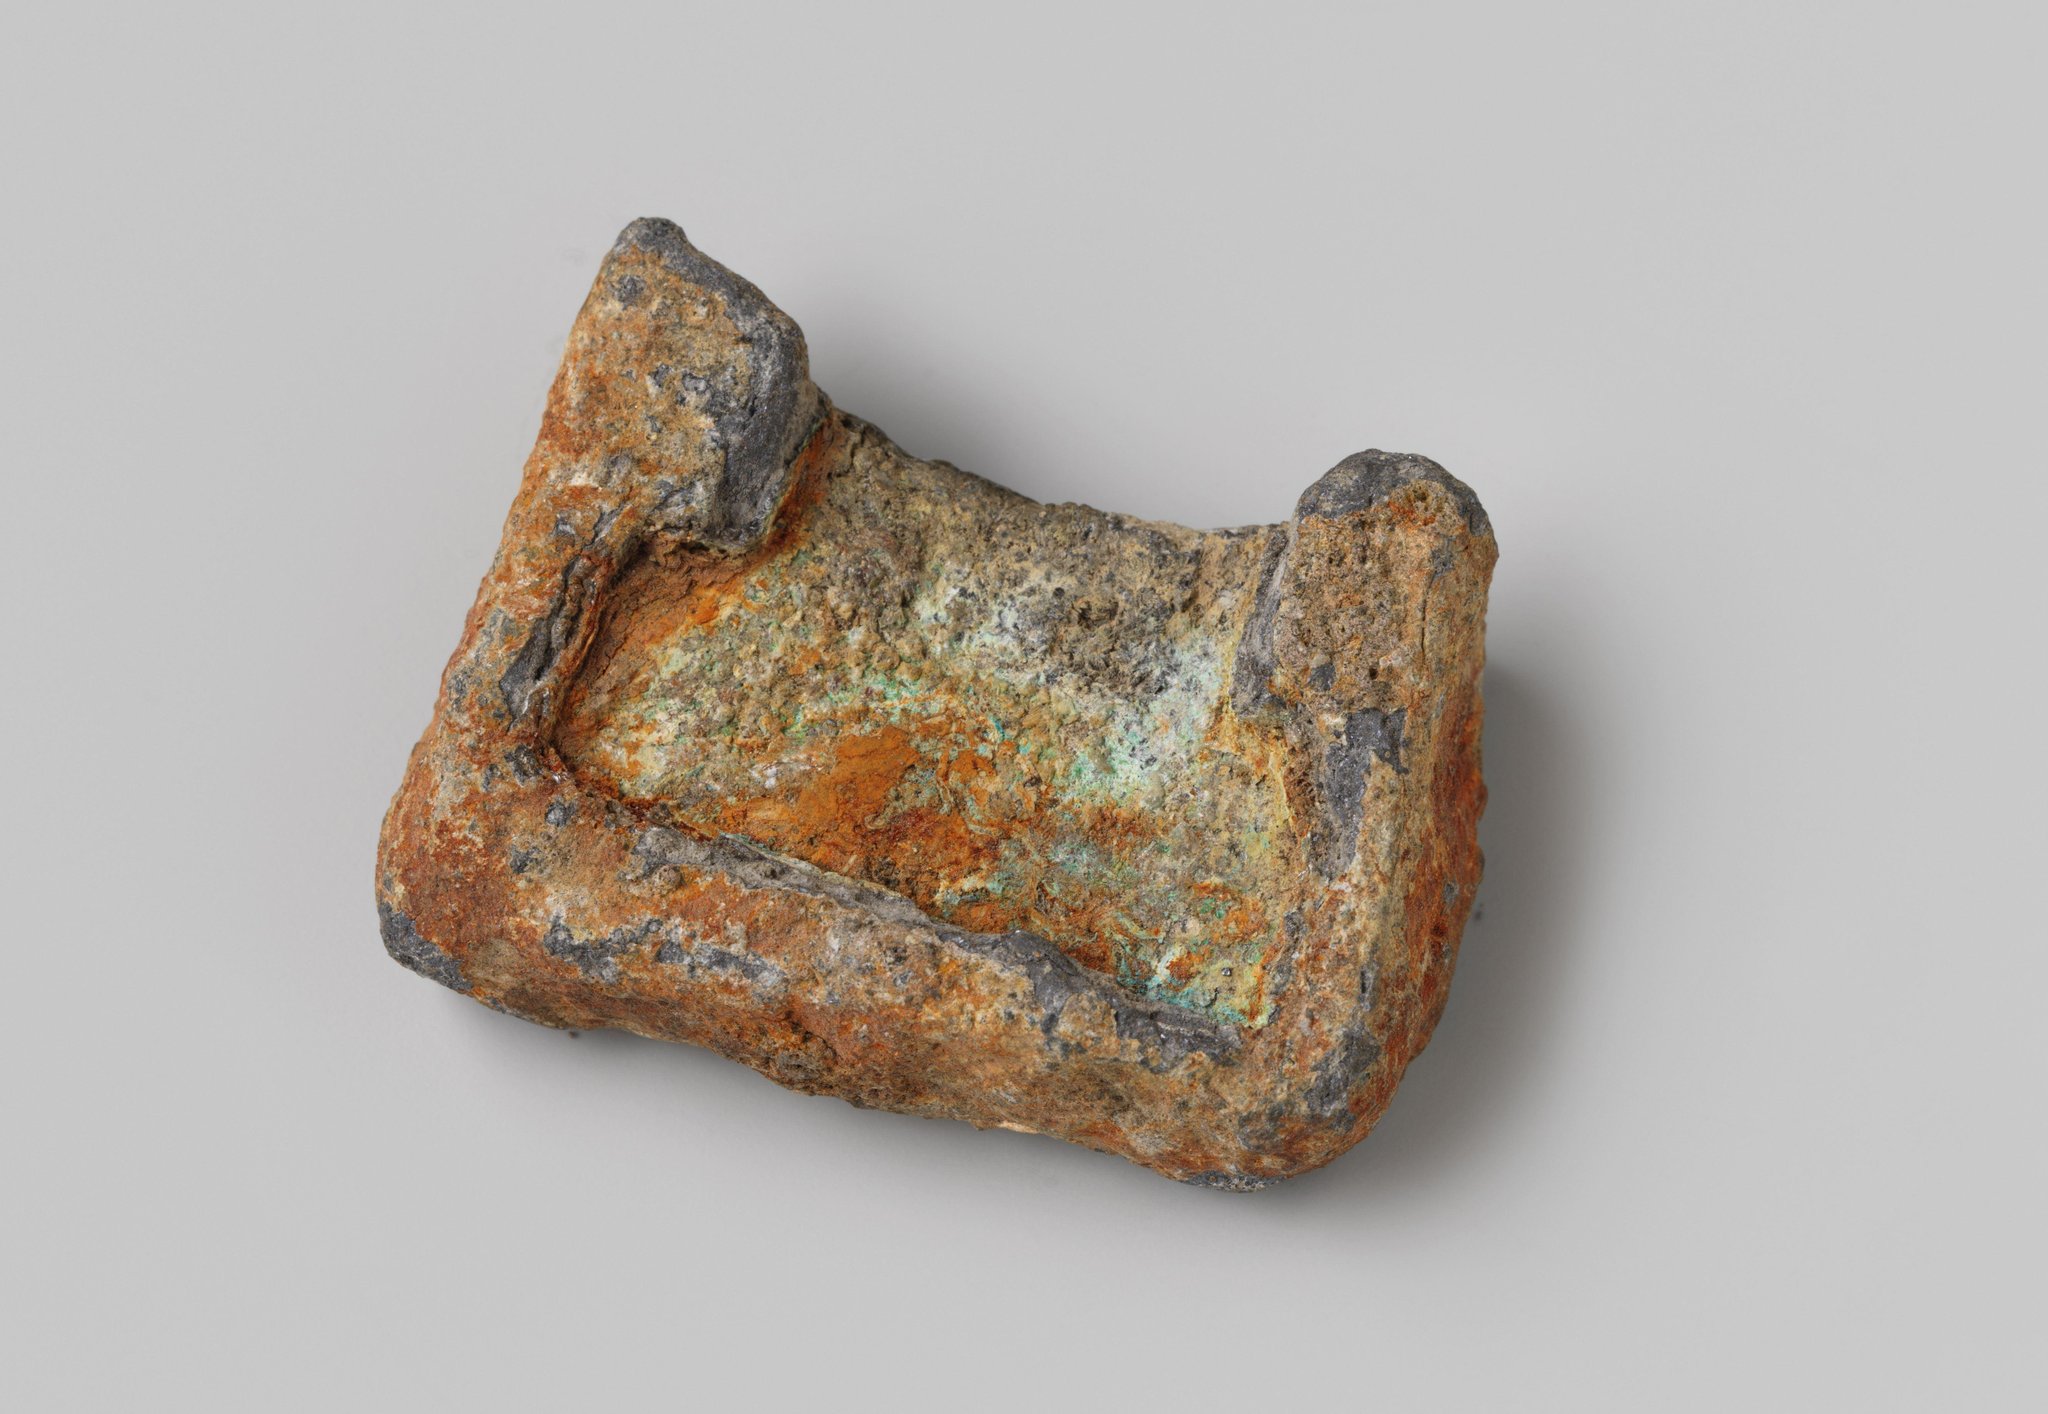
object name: fragment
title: Fragment van lood uit het wrak van de Oost-Indiëvaarder Hollandia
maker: Anonymous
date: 1700-1743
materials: lead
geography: netherlands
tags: verenigde oostindische compagnie, hollandia (schip), annet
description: Varied parts or fragments, unidentified and miscellaneous parts or fragments; fragm.